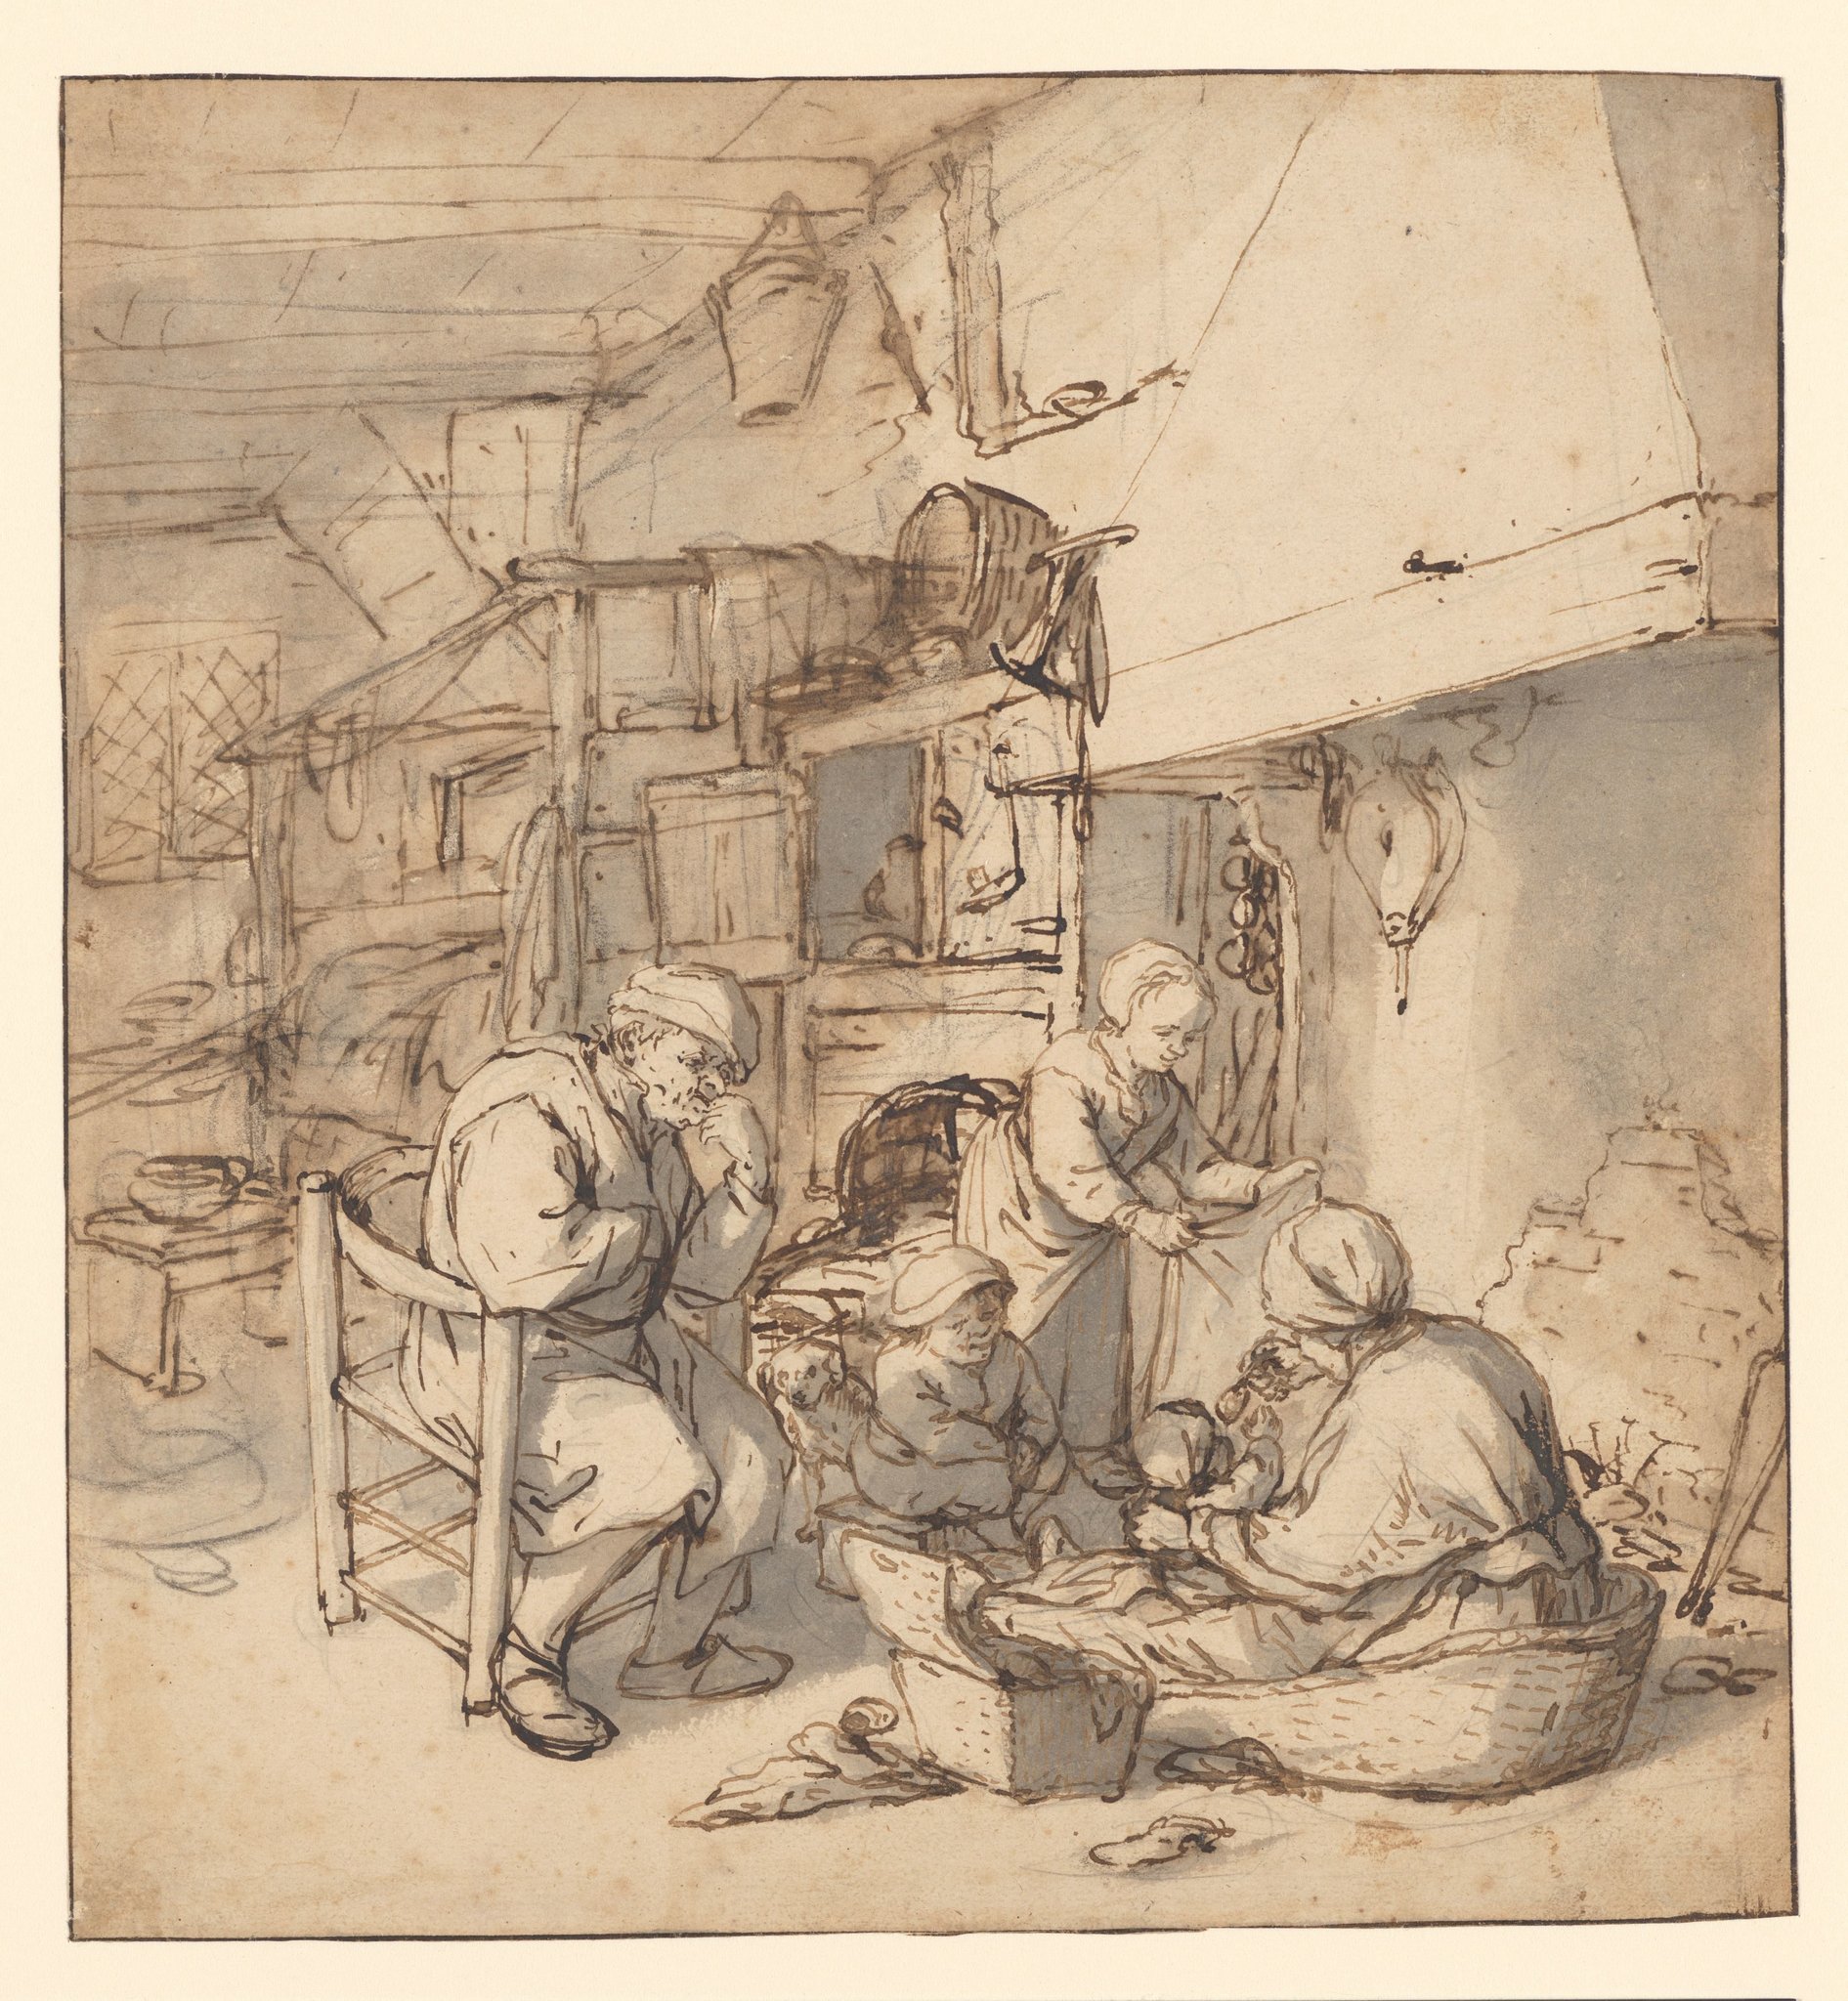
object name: drawing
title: Peasant Family around the Fireplace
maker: adriaen van ostade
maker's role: draughtsman, painter, print maker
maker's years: 1610-1685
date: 1650-1660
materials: chalk, ink, paper, pencil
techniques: brush, pen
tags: family group, especially parents with their child(ren), feeding a baby, communal rooms, family life at home, hearth and stove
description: A family is gathered about the hearth in a meagre interior. By the fire, the oldest of the girls is drying a cloth. The mother is sitting beside a cradle feeding porridge to the youngest, while father and son look on. It was a favourite theme of Adriaen van Ostade’s, and he often introduced tiny variations: there was evidently considerable demand for these depictions of this simple, yet contented family.